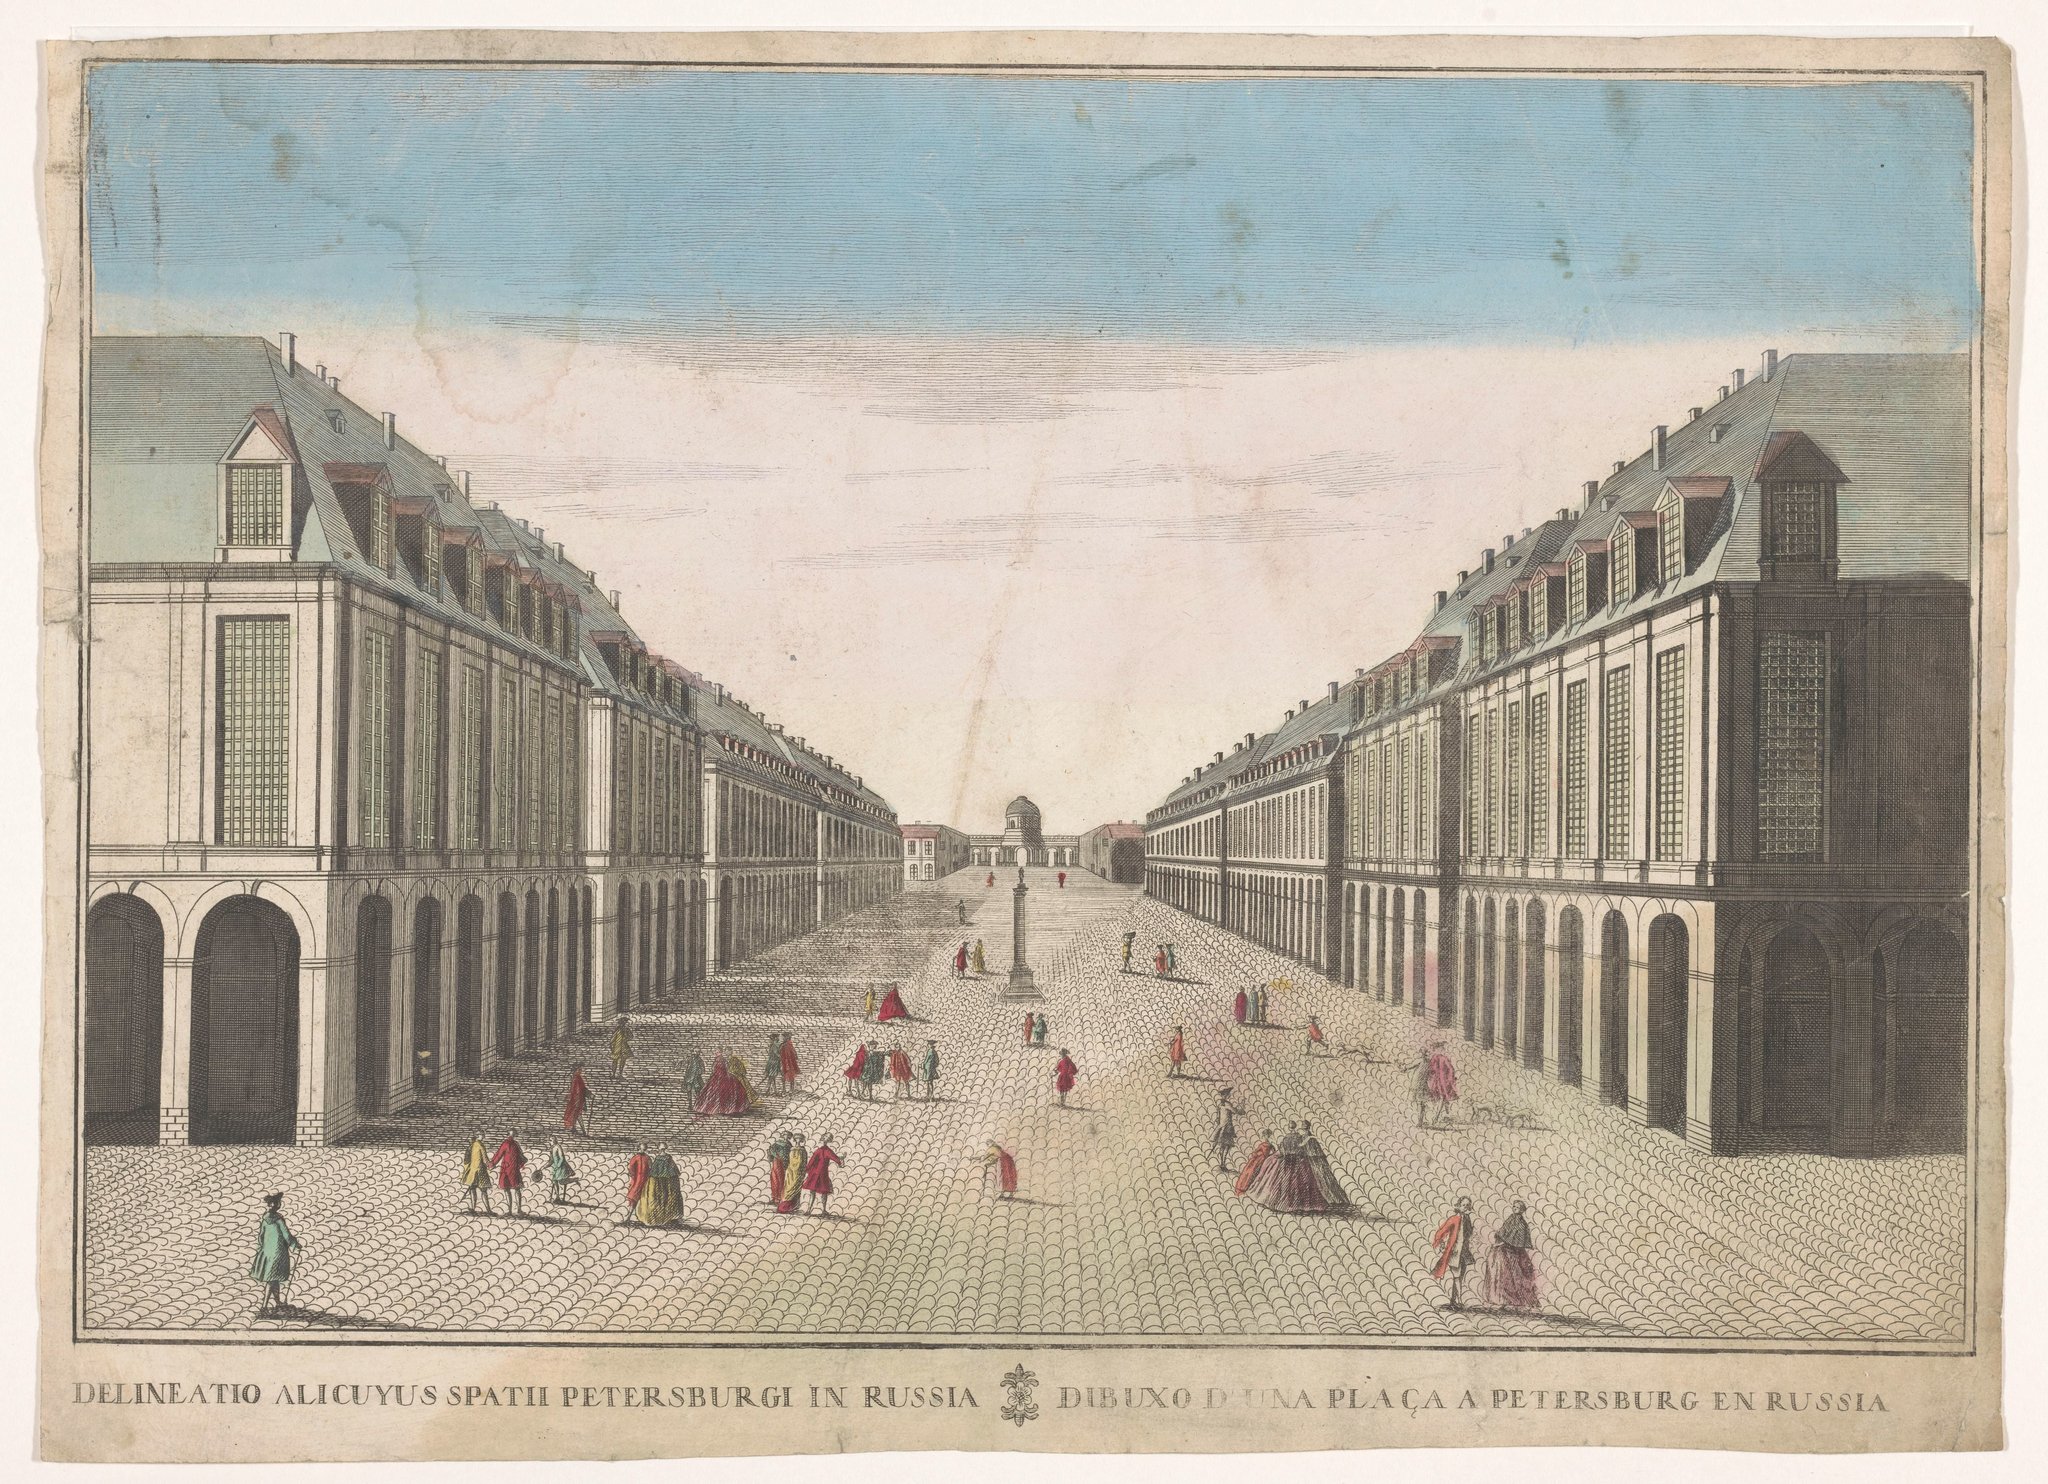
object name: opticaprent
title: Gezicht op een plein te Sint-Petersburg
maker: Anonymous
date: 1700-1799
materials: paper, watercolor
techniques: brush, etching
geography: bassano del grappa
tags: column (marking grave), square, place, circus, etc. (+ city(-scape) with figures, staffage)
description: Mogelijk linksonder genummerd geweest: D 1.